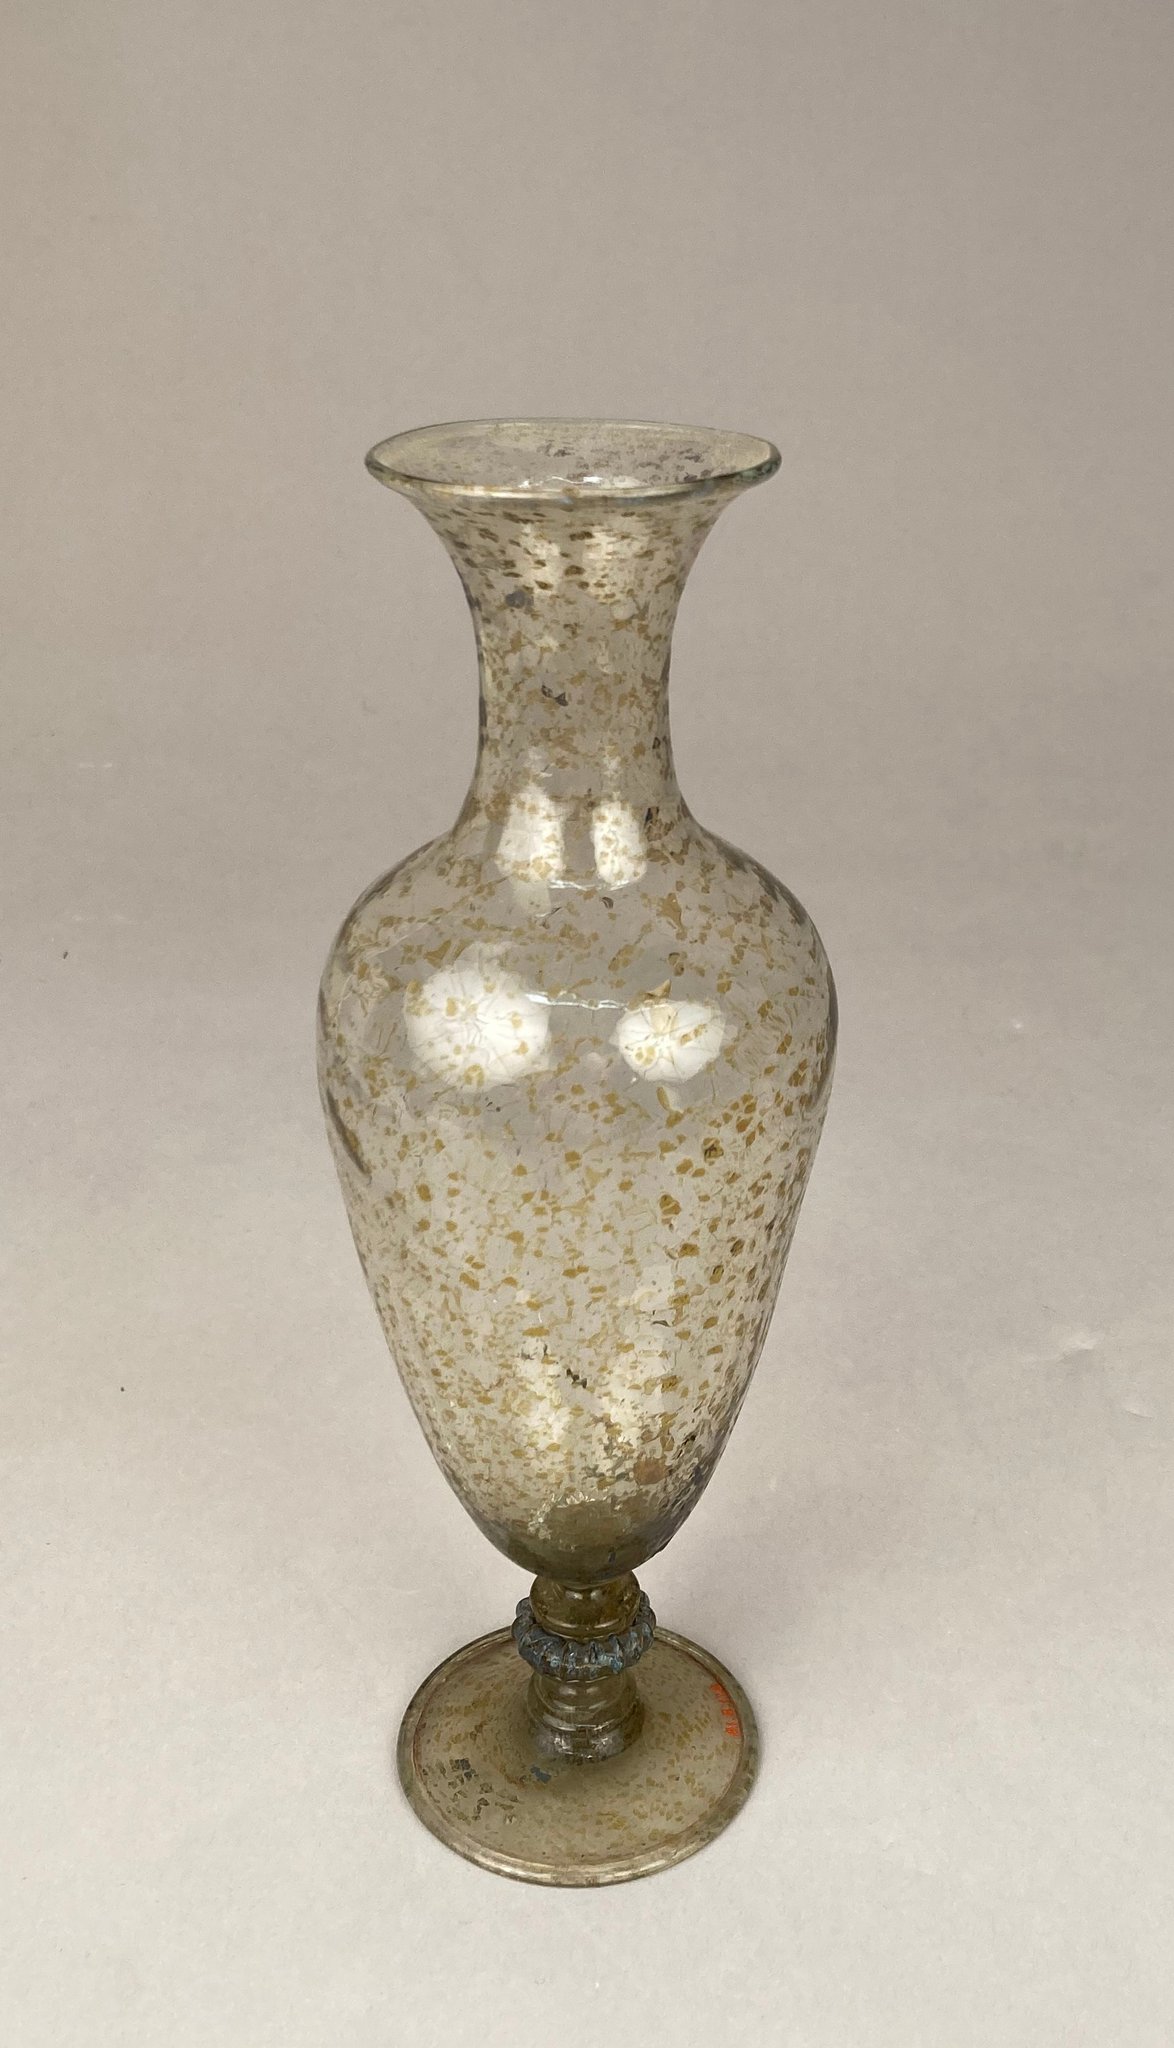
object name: vase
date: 1801-1900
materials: glass